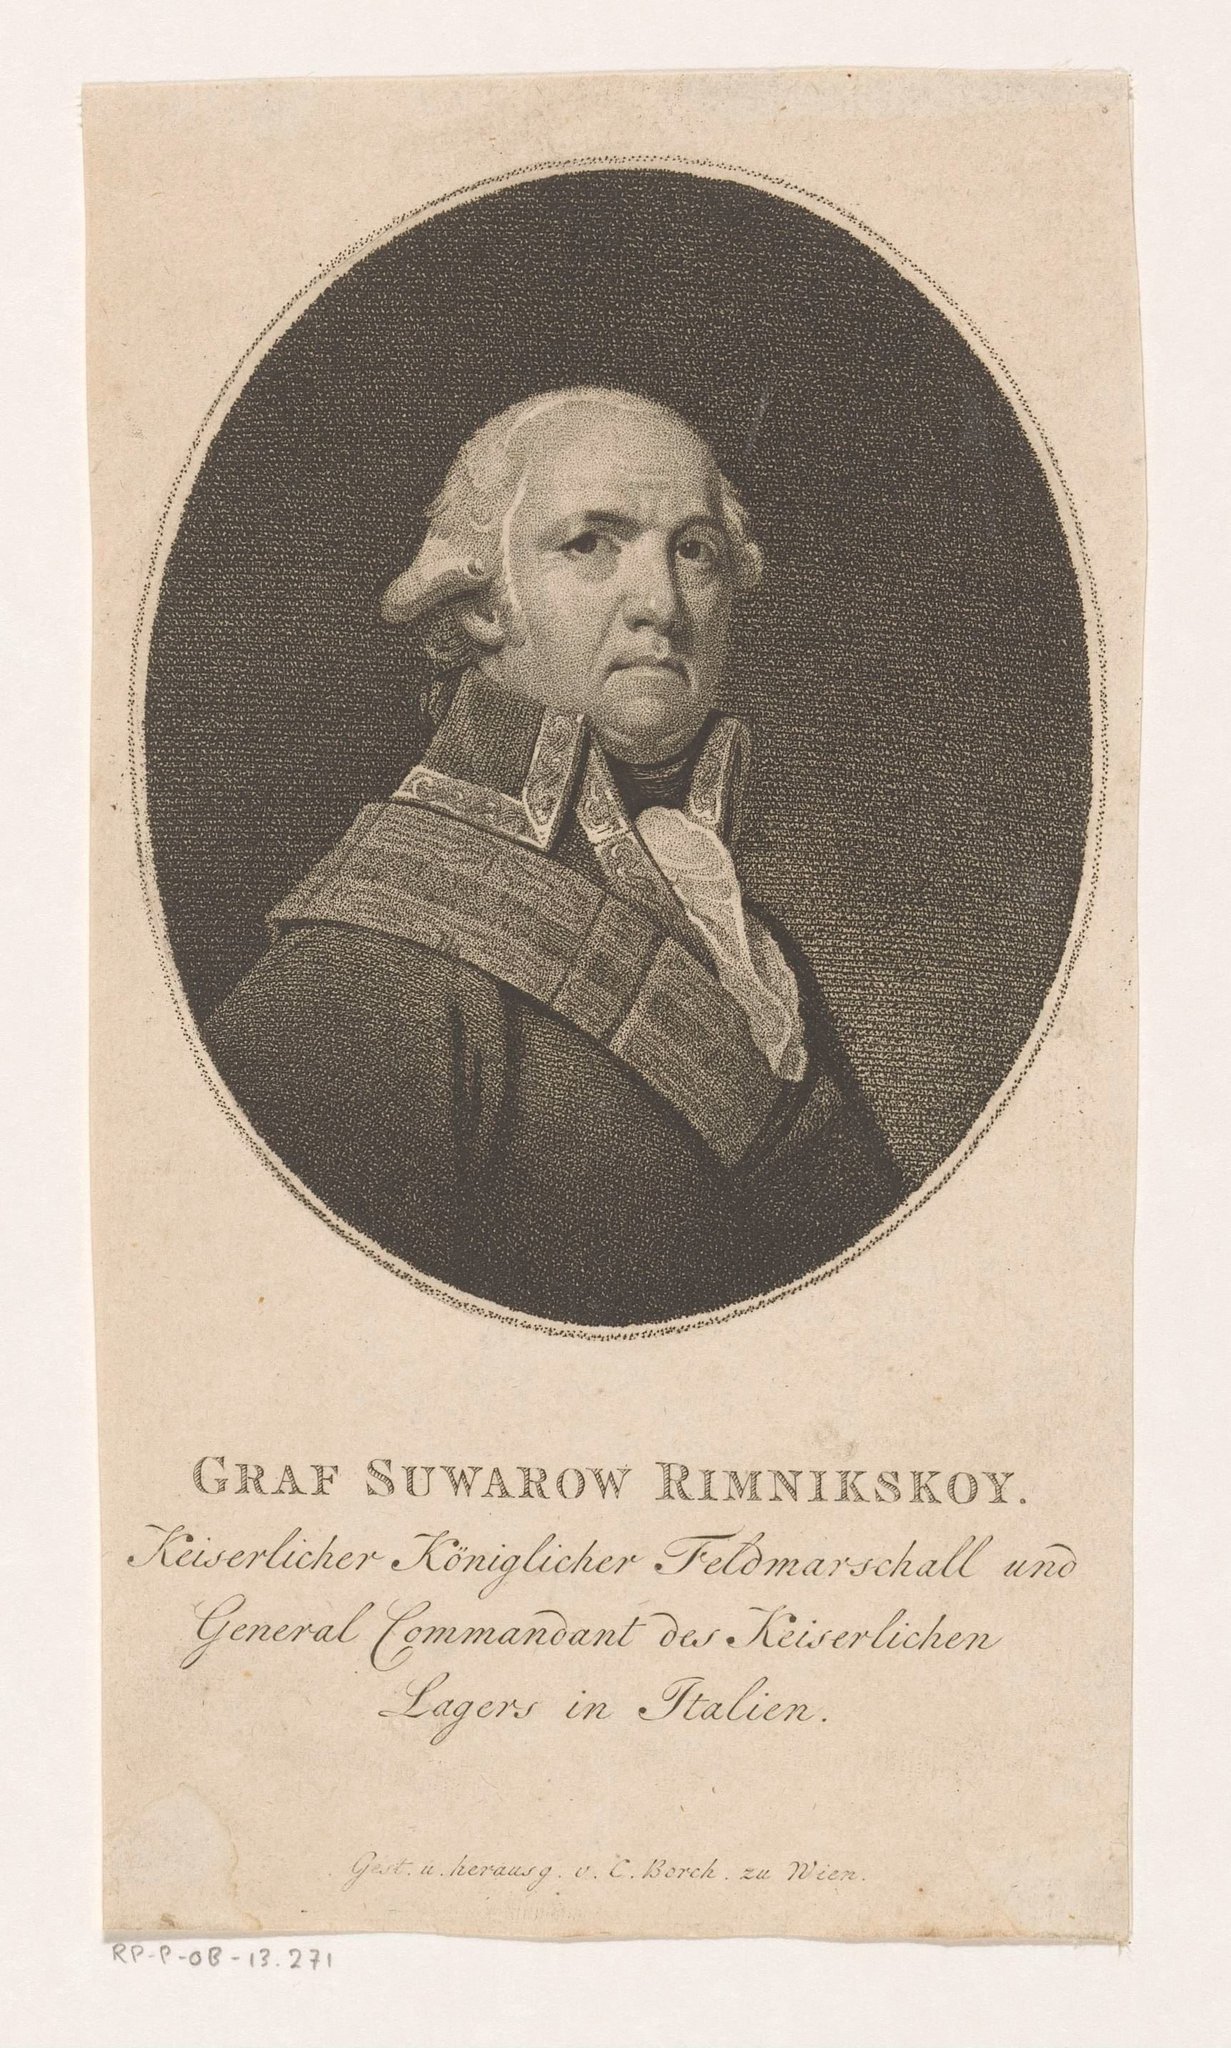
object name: print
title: Portret van Aleksandr Soevorov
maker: c. borch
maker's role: print maker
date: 1799-1800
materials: paper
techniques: stippling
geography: vienna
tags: historical persons, (military) uniforms